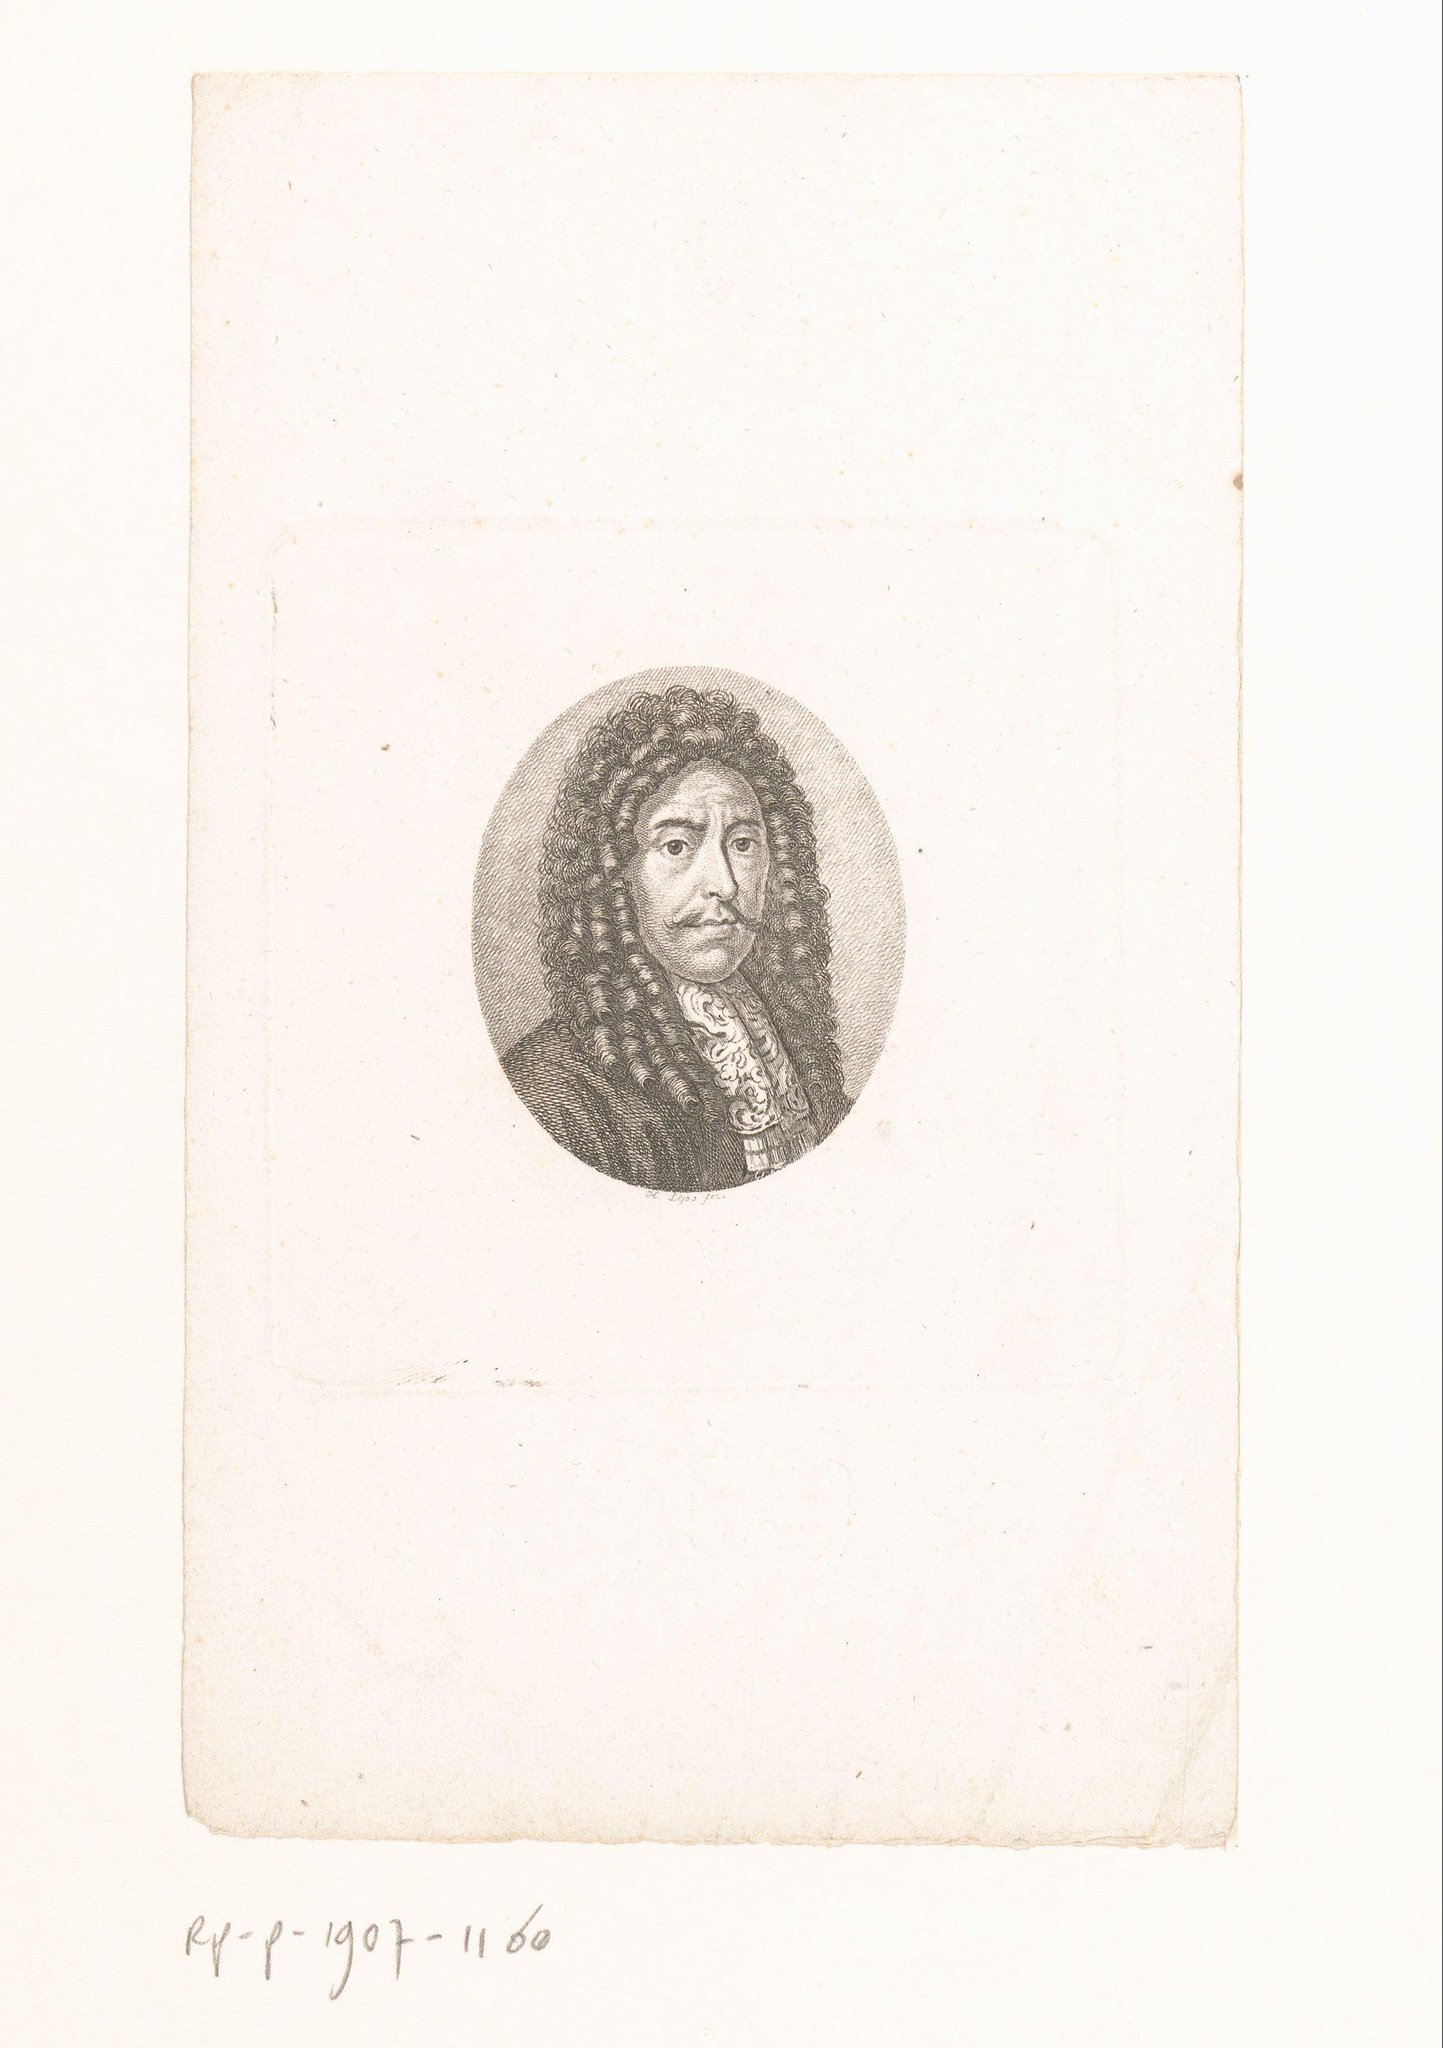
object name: print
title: Portret van Joseph Werner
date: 1768-1817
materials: paper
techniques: engraving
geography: berlin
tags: painter, joseph werner (ii), historical persons, portrait, self-portrait of artist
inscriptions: collector's mark: Lugt 2228